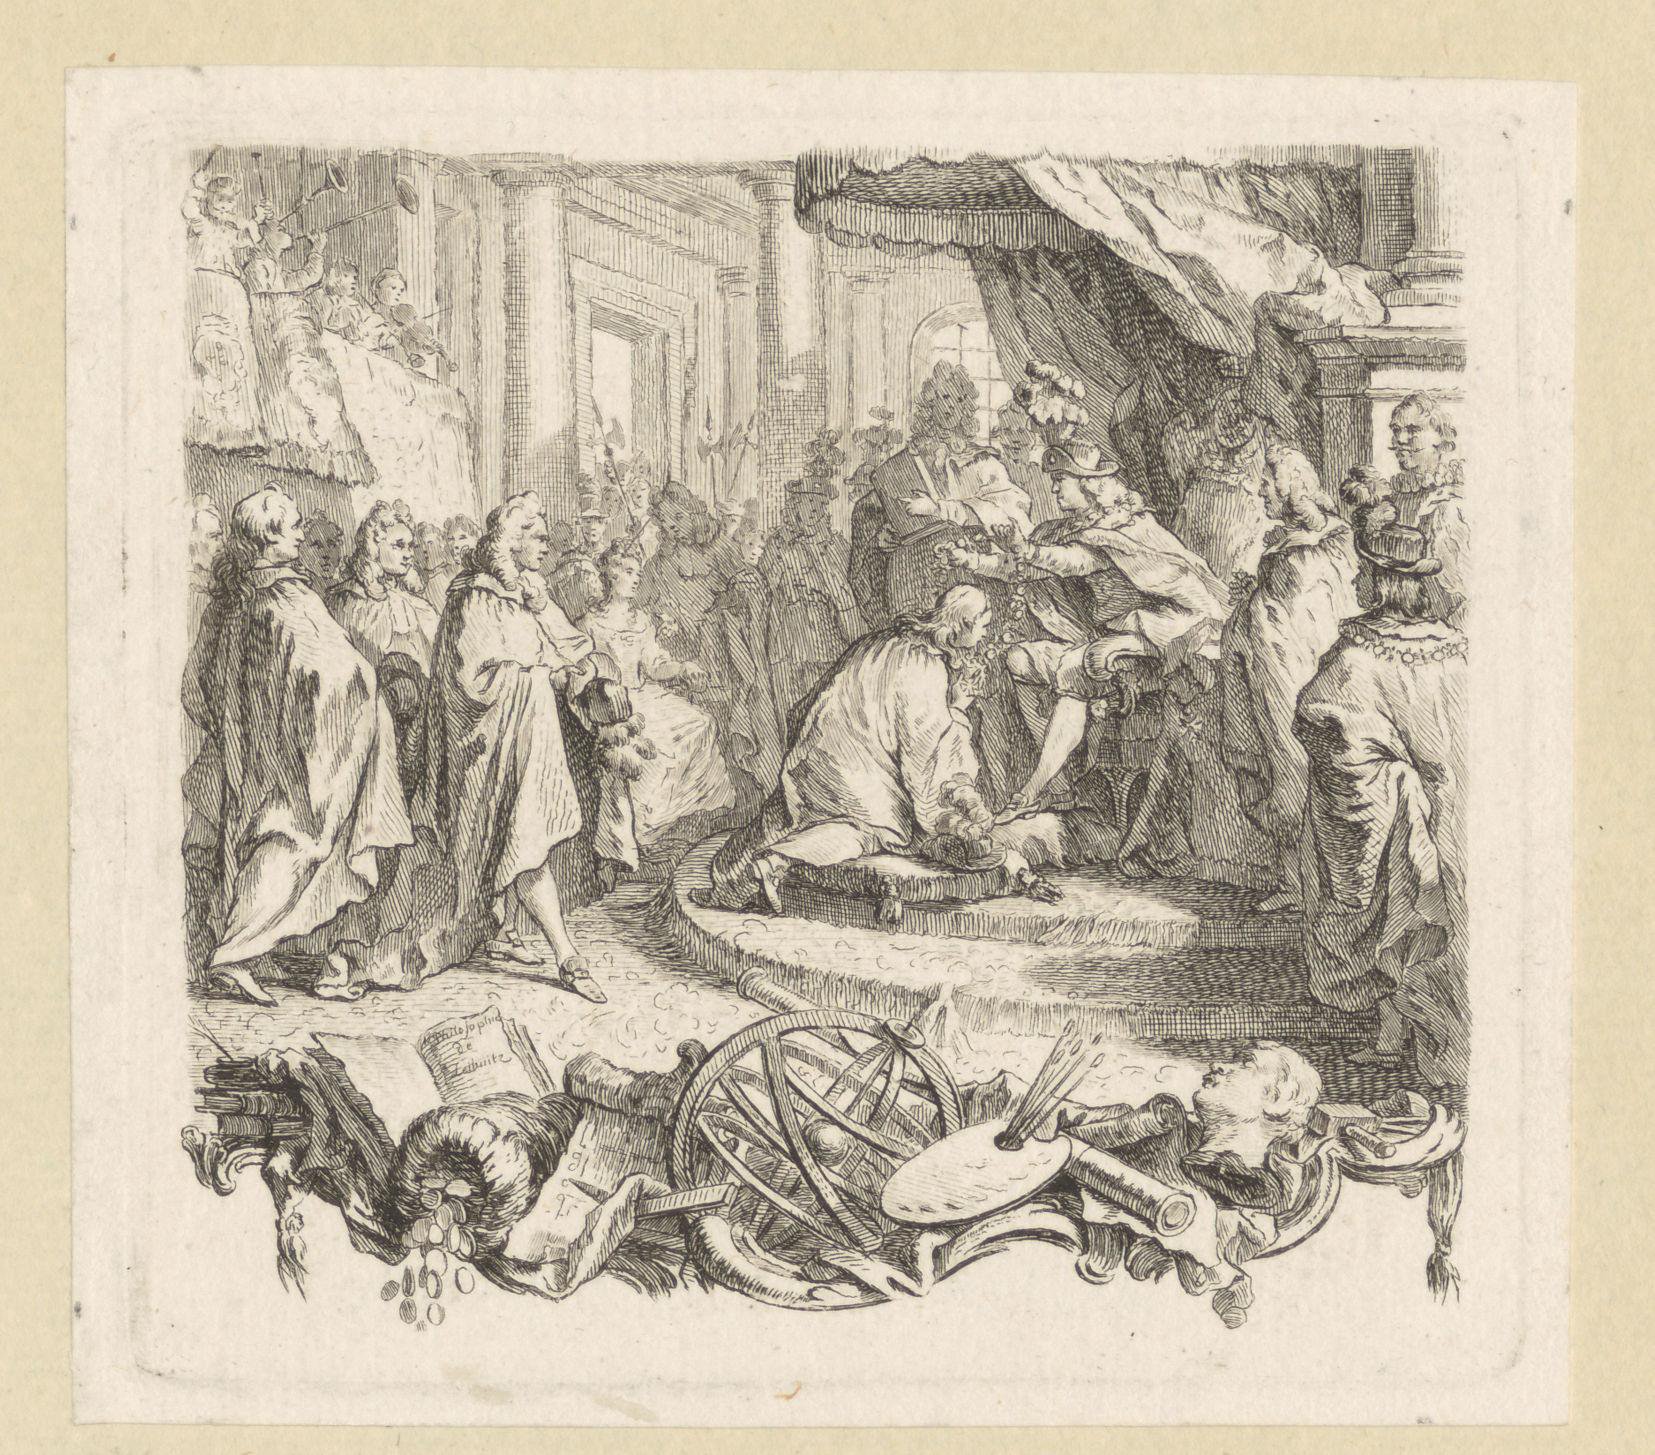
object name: book illustration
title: Stichting van de zwarte adelaarsorde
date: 1751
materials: paper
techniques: etching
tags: knighthood order (with name) - insignia of a knighthood order, e.g.: badge, chain (with name of order), historical events and situations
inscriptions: collector's mark: Lugt 240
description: Prent ook gebruikt in: Frederik de Grote. Mémoires pour servir a l'histoire de la maison de Brandebourg. Sanssouci, Frederik de Grote, 1751.